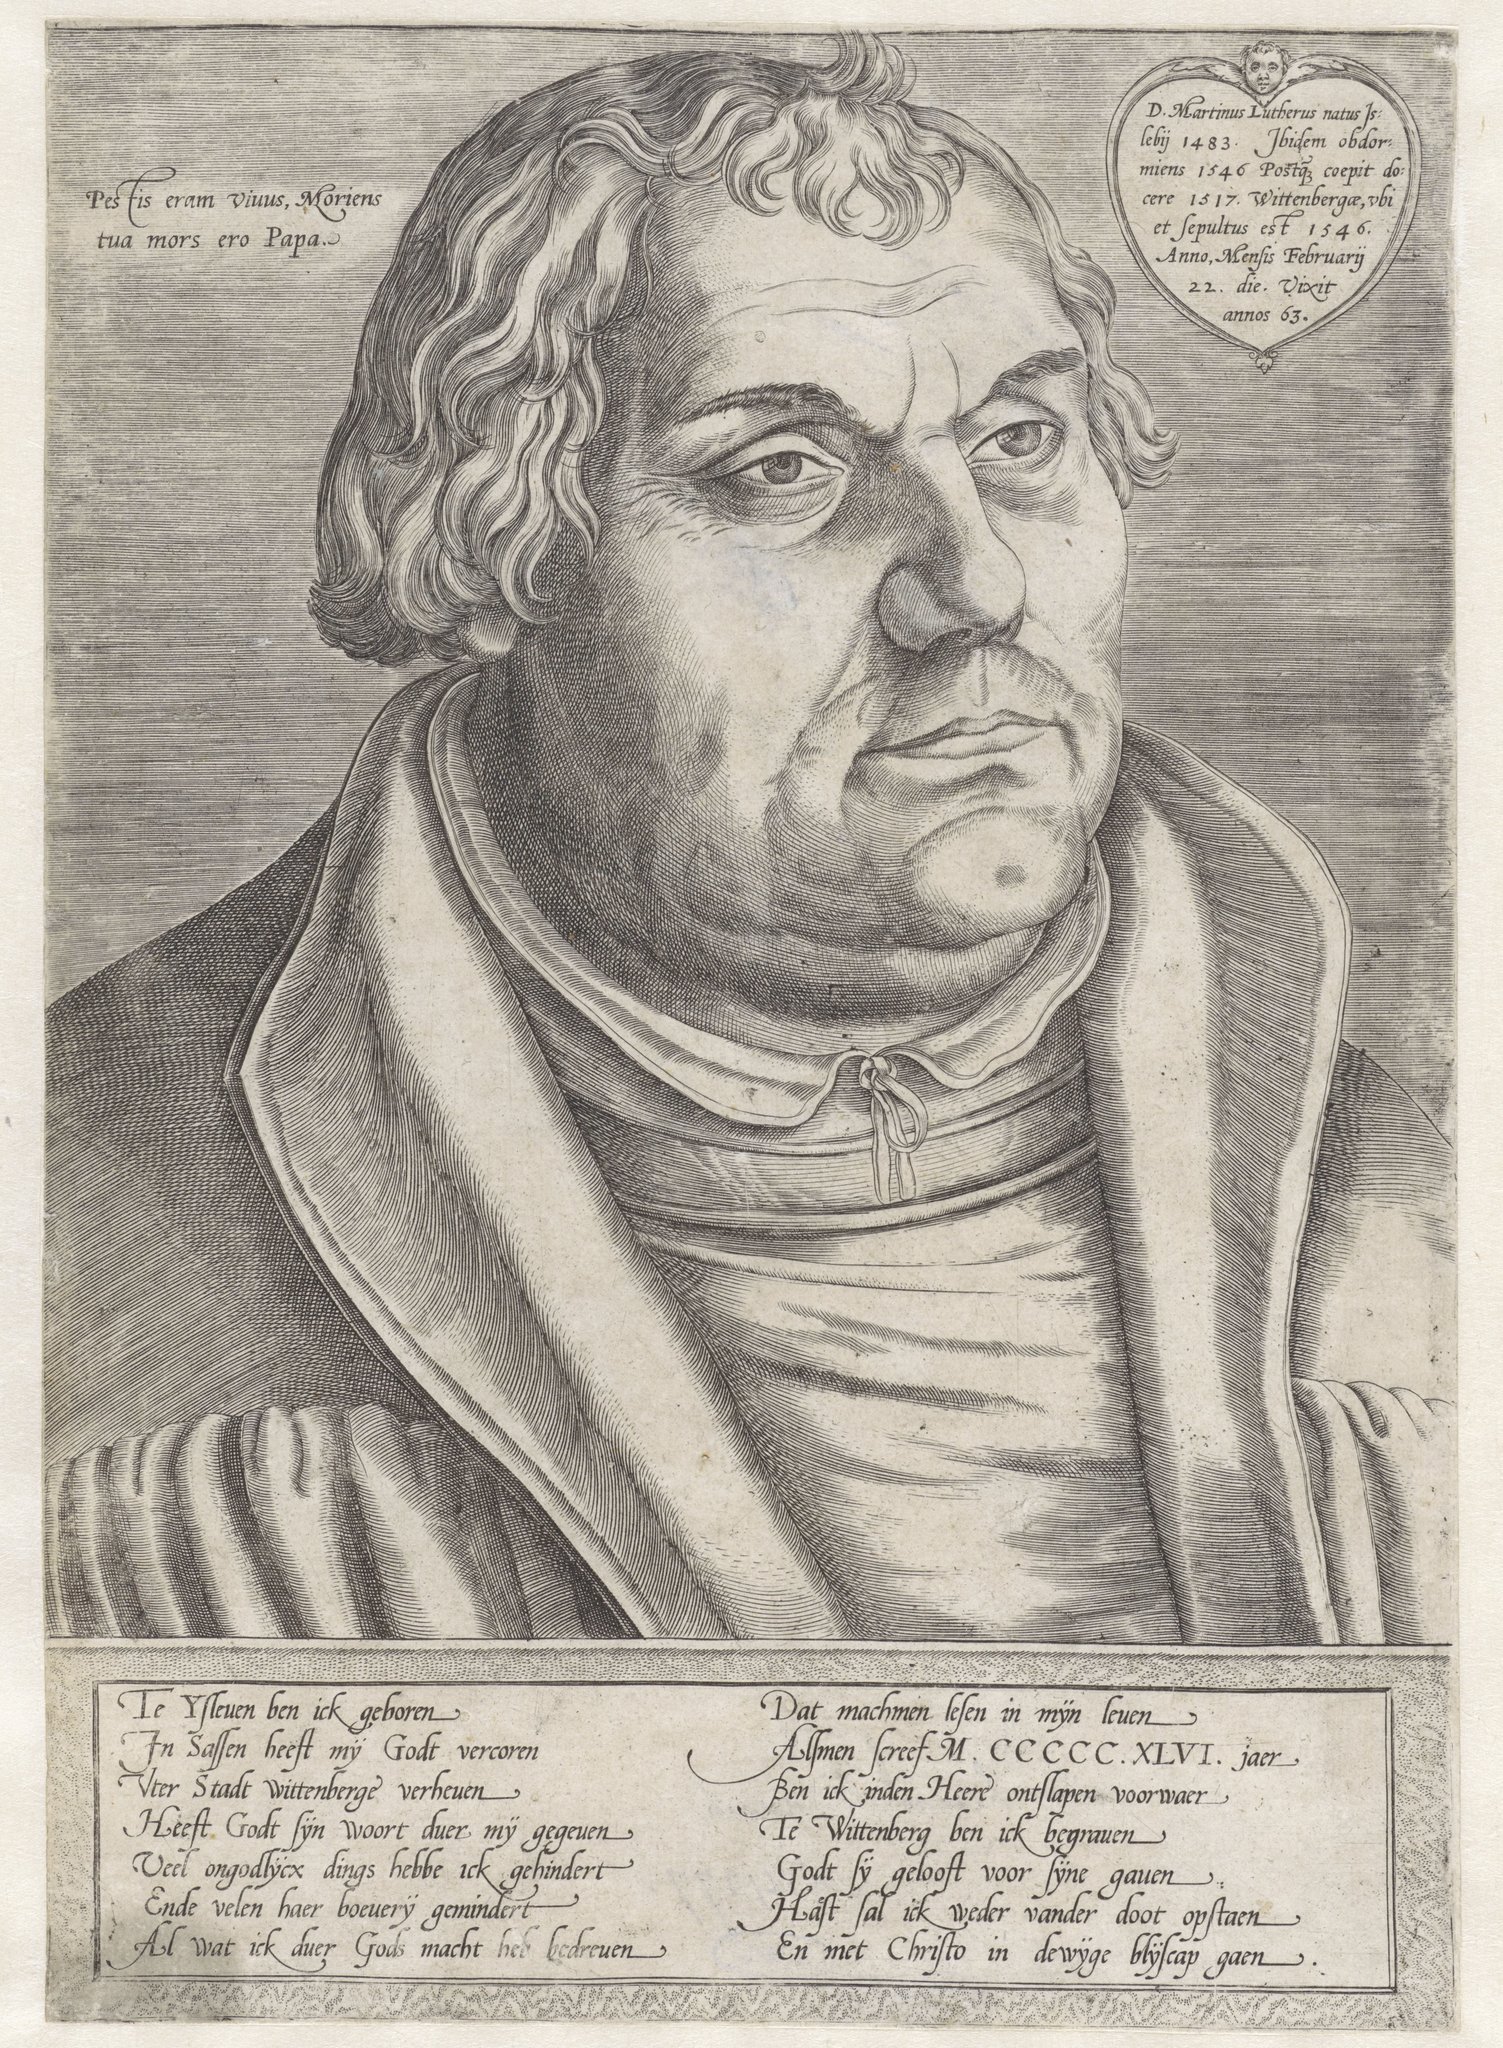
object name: print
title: Portret van Martin Luther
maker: paulus van wtewael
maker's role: die cutter, draughtsman, print maker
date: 1565-1611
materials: paper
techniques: engraving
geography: northern netherlands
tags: priest, martin luther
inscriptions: collector's mark: Lugt 2228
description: Portret van de theoloog Martin Luther. Rechtsboven in een hartvormig cartouche een achtregelig opschrift met biografische gegevens in het Latijn. Linksboven twee regels in het Latijn. In het kader onder zijn portret een veertienrgelig gedicht, in twee kolommen, in het Nederlands.